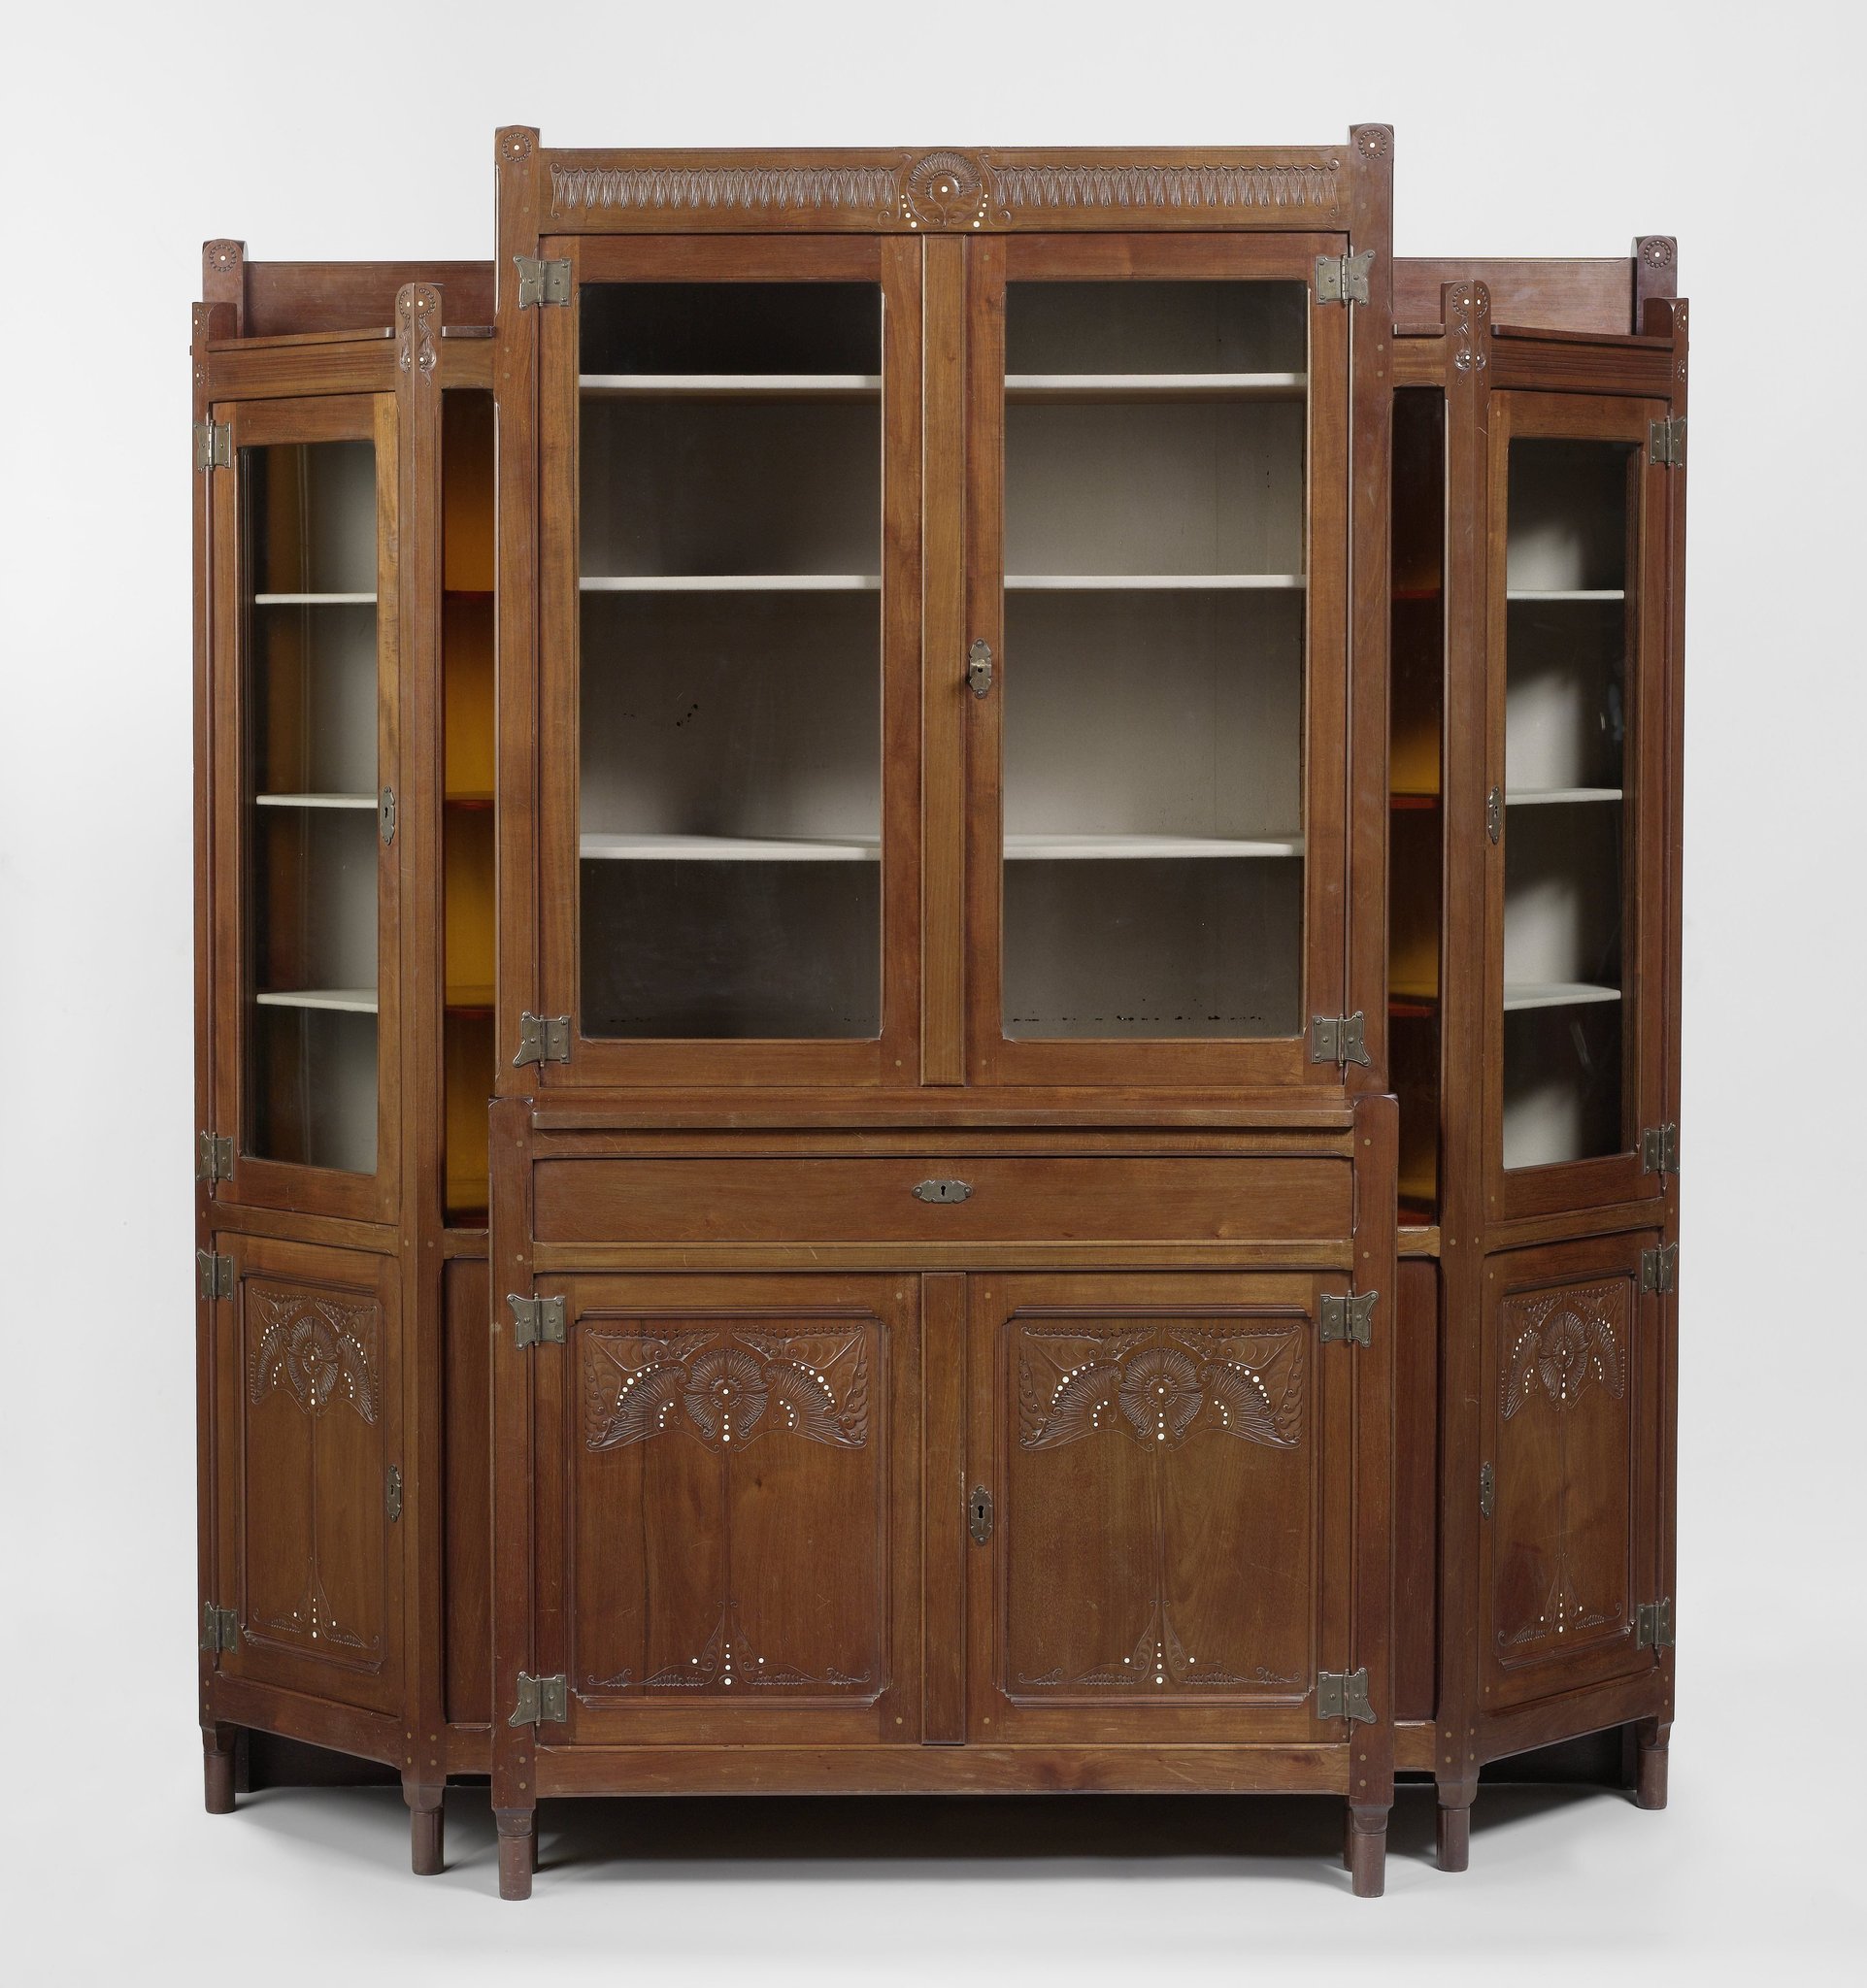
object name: case furniture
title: Vitrinekast bestaande uit een middendeel en twee schuin geplaatste zijdelen met gesneden florale motieven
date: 1905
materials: brass, glass, ivory, wood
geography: amsterdam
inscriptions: label: ‘'t Binnenhuis, Rokin 120, Amsterdam.’, monogram: ‘JvdB’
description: Vitrinekast van mahoniehout bestaande uit een middendeel en twee schuingeplaatste vijfhoekige zijdelen rustend op slanke hoge poten. Het middendeel bestaat uit een onderkast met twee deuren en daarboven een lade en een terugwijkende bovenkast met twee hoge vensters en een fries. De terugwijkende zijdelen, die lager zijn dan het middendeel, bestaan uit een deur met daarboven een hoog venster en worden geflankeerd door schuin geplaatste smalle delen die bestaan uit een paneel met daarboven een hoog venster. Aan de achterzijde van de zijdelen is een opstaande regel. De stijlen, die allen uitsteken, de deuren en het fries bevatten gesneden florale motieven deels ingelegd met stippen van ivoor. Achter de vensters hangt witte vitrage. De kast bevat messing beslag in de vorm van scharnieren en sleutelplaten.